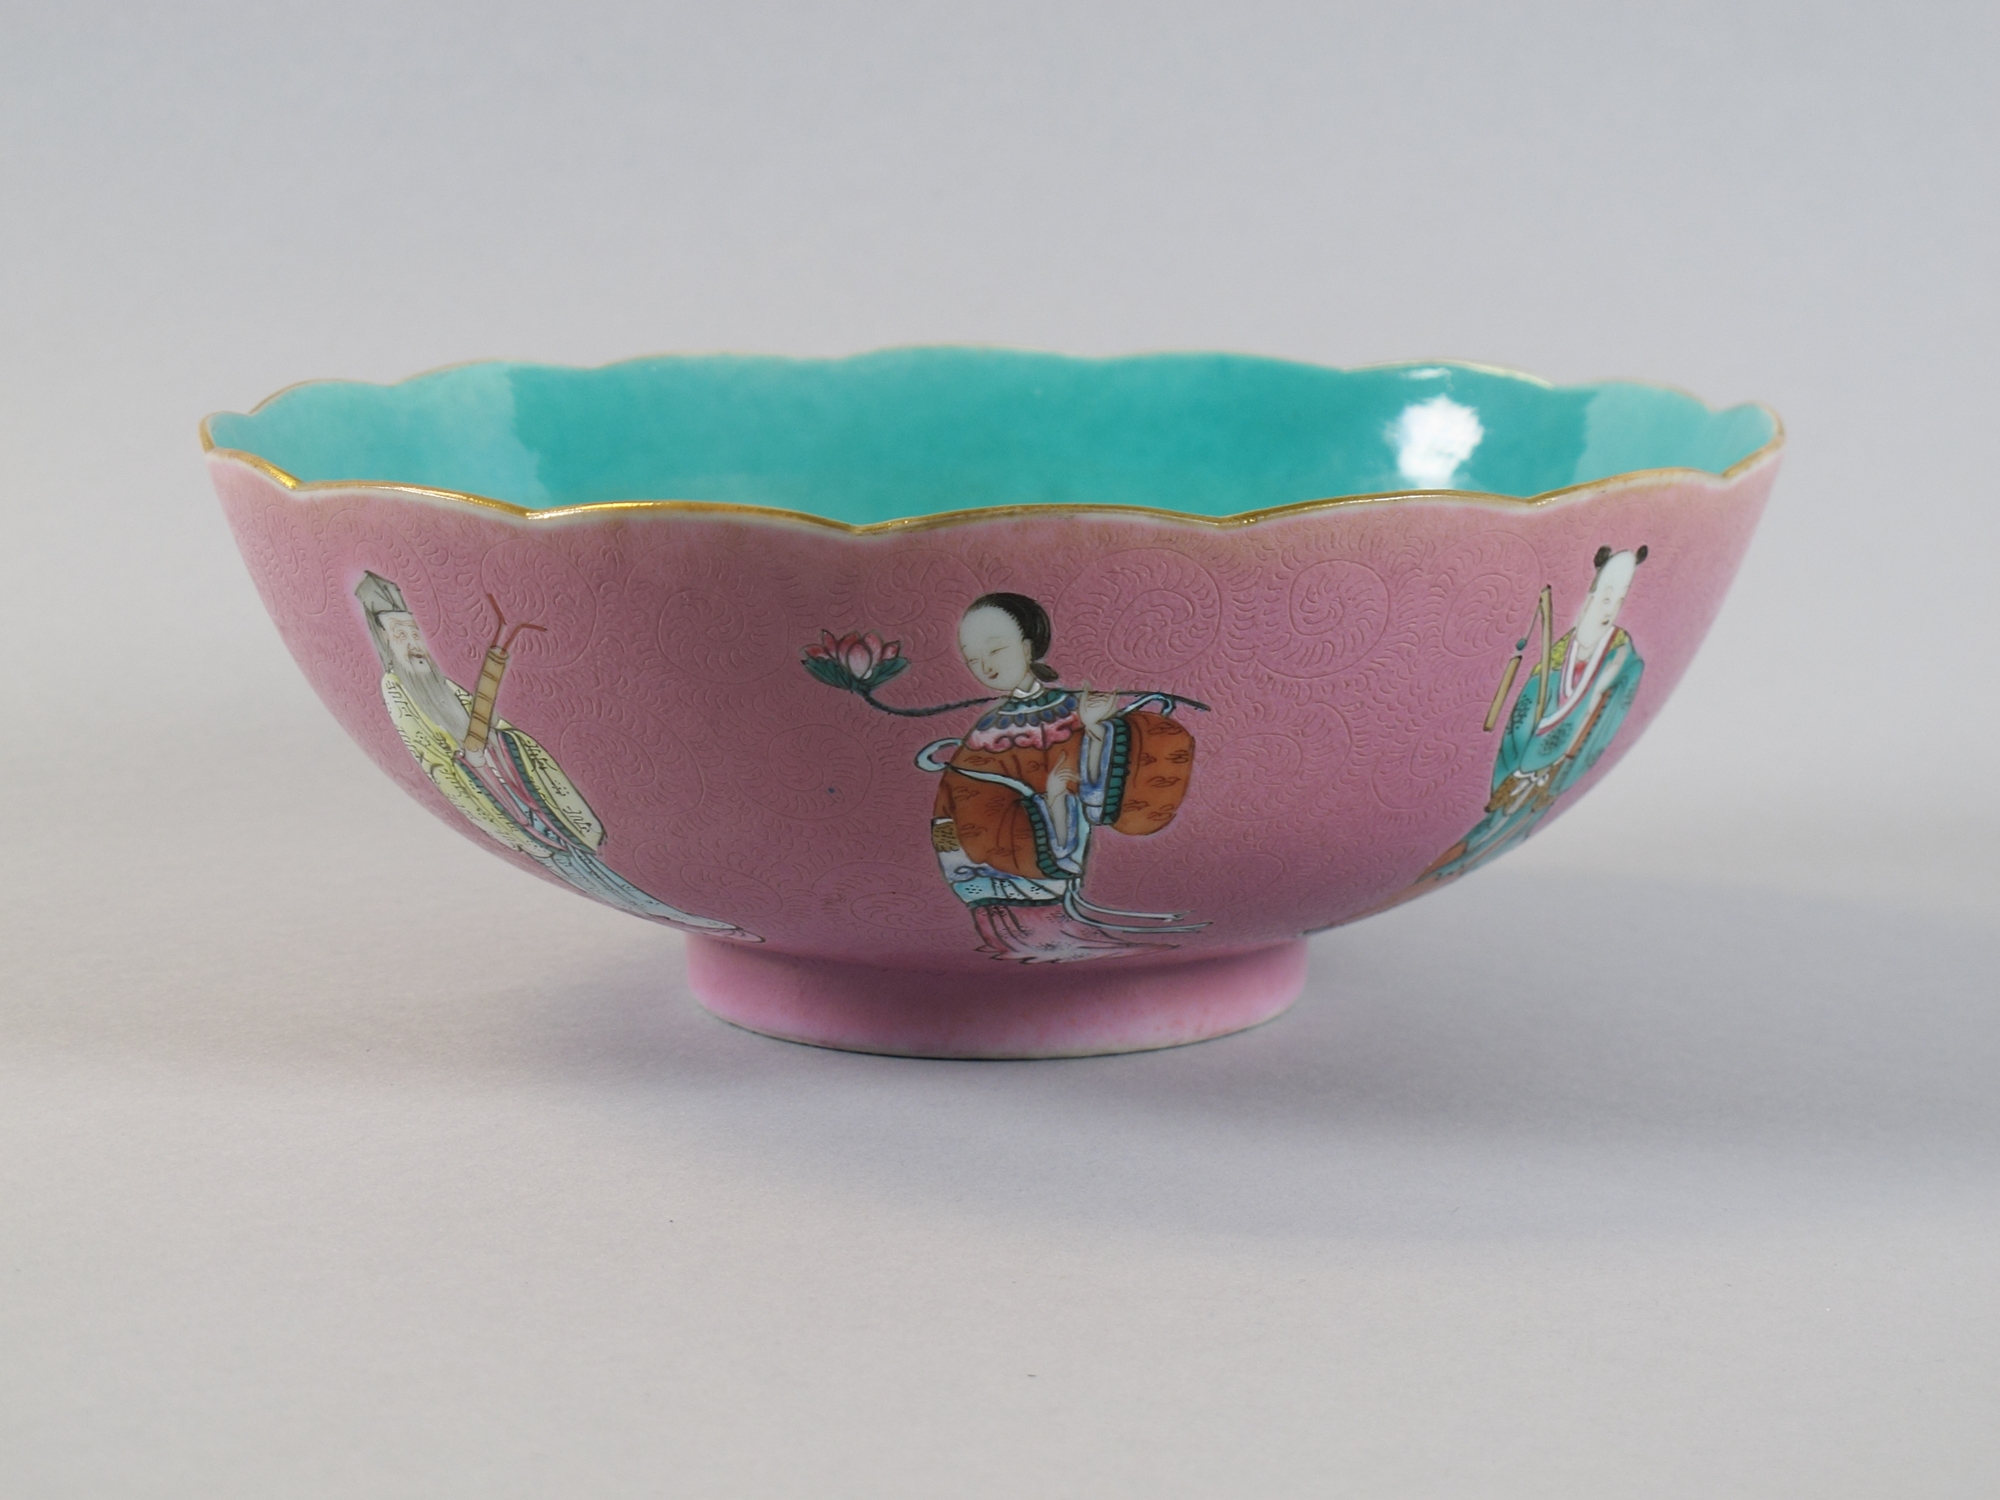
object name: bowl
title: Bowl with the Eight Immortals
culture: chinese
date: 1767-1833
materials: enamel, porcelain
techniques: engraving, overglaze, painting, polychrome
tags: men,women